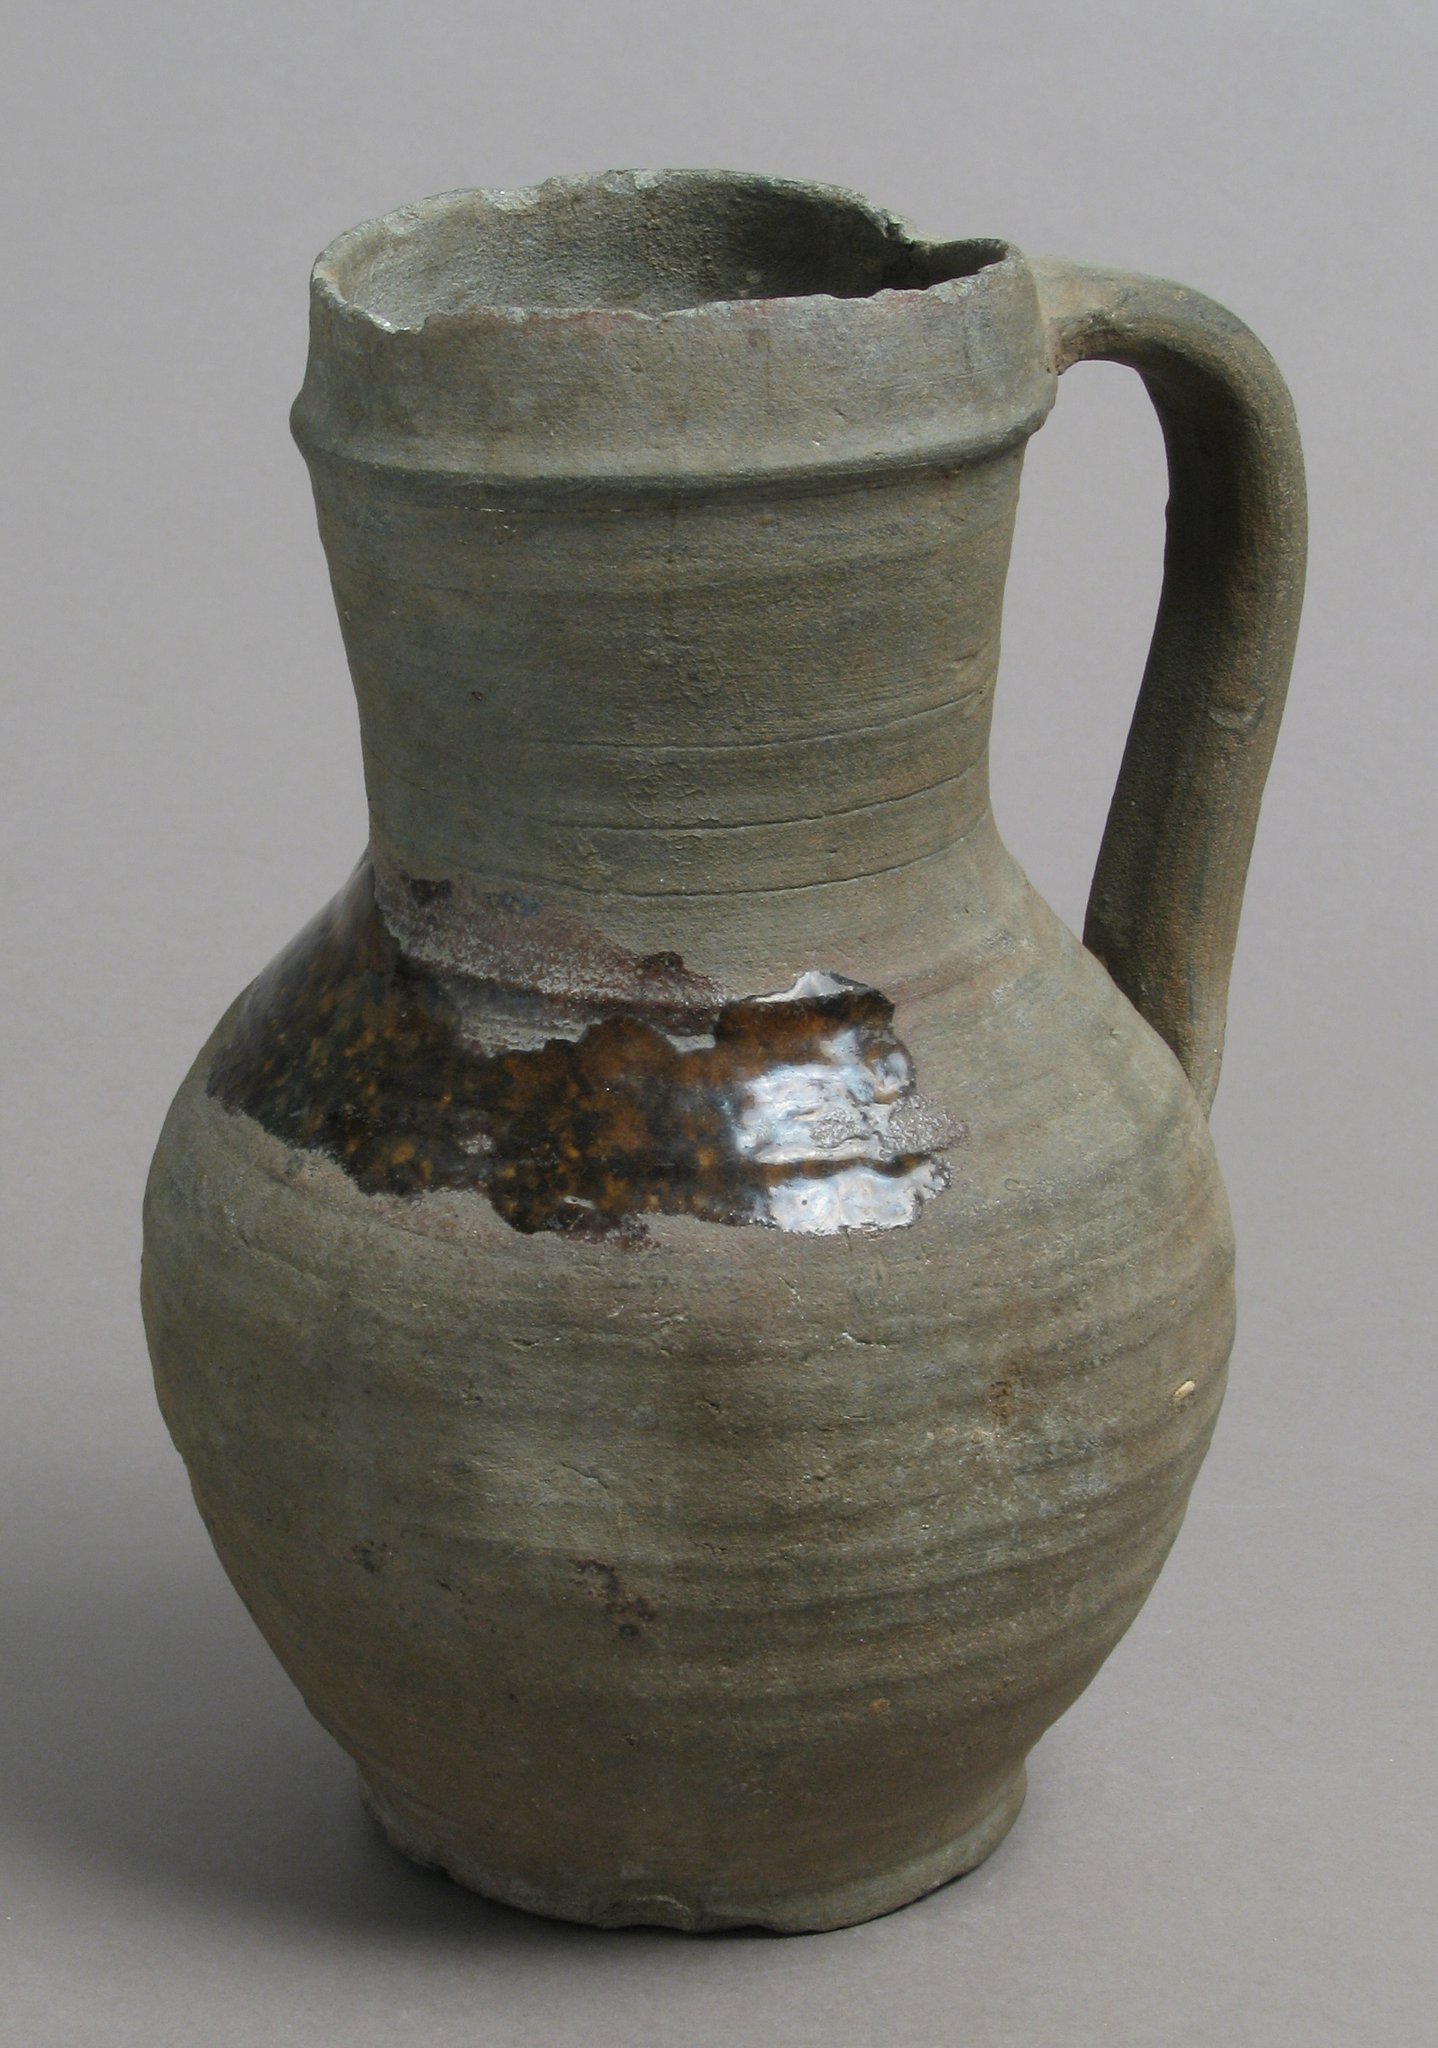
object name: jug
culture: german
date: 1175-1250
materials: earthenware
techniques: salt glaze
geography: germany